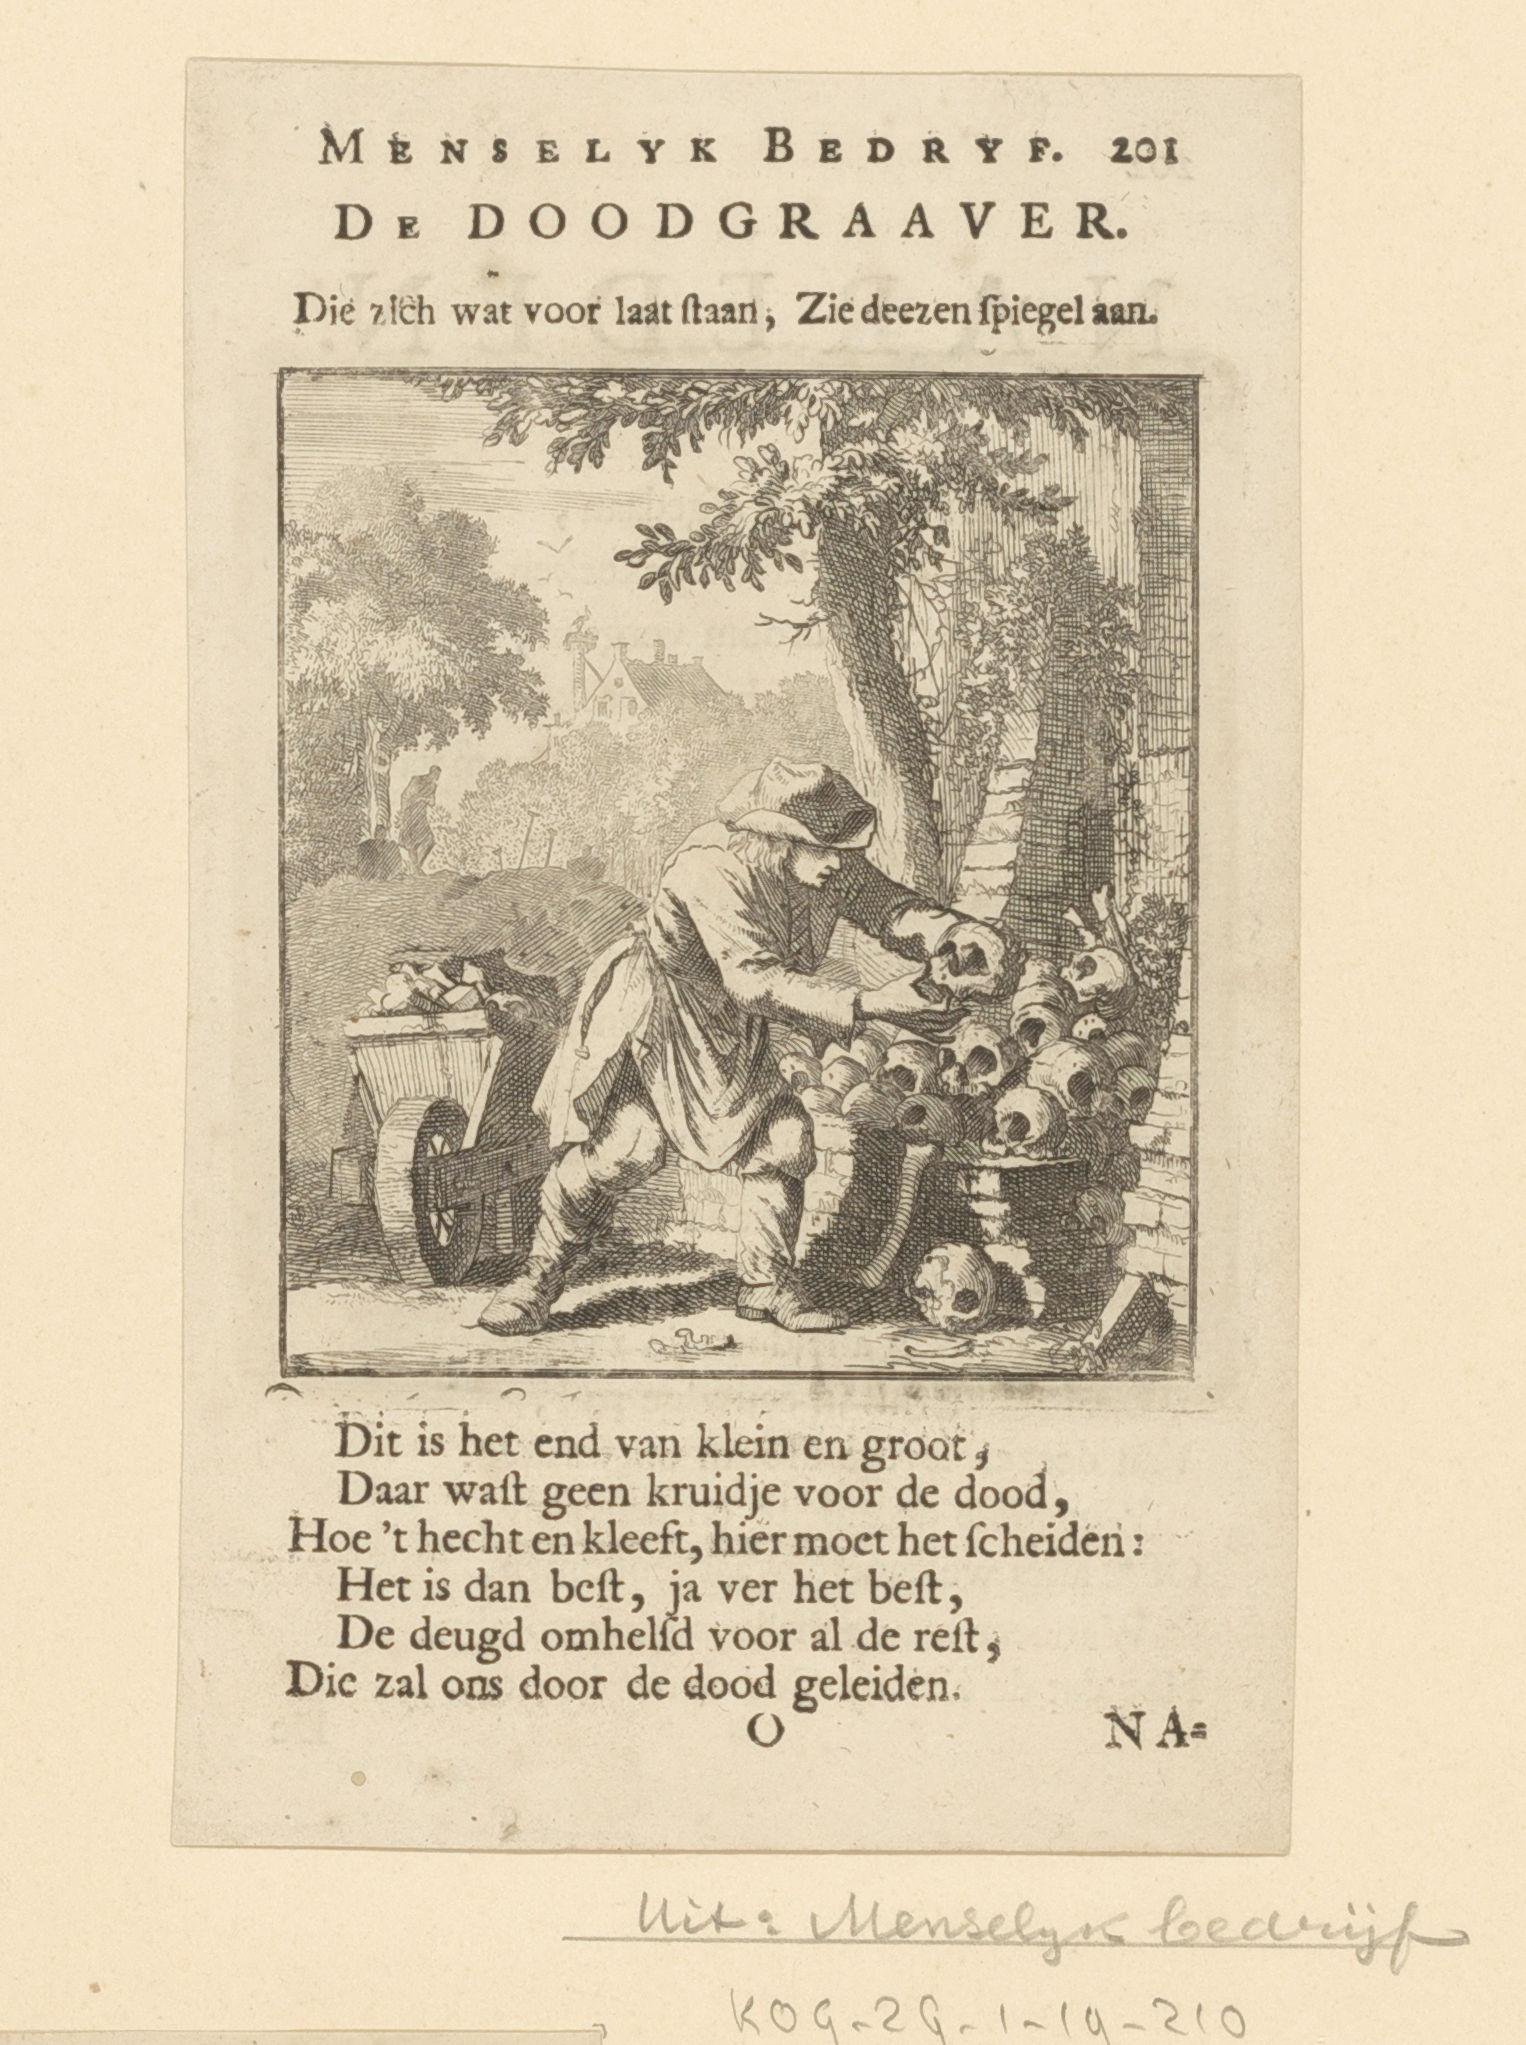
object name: print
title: Het Menselyk Bedryf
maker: jan luyken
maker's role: draughtsman, print maker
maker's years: 1649-1712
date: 1694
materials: paper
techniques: etching, letterpress printing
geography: amsterdam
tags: grave digger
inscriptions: collector's mark: Lugt 1641, collector's mark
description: Een doodgraver is op het kerkhof graven aan het ruimen. Met een spreuk boven en een zesregelig vers onder de plaat. Genummerd rechtsboven: 201. Onderwerpsrubrieken binnen de Atlas Zeden en Gewoonten: Des Menschen Begin, Midden en Einde. Begrafenissen, aansprekers, doodgravers, enz.